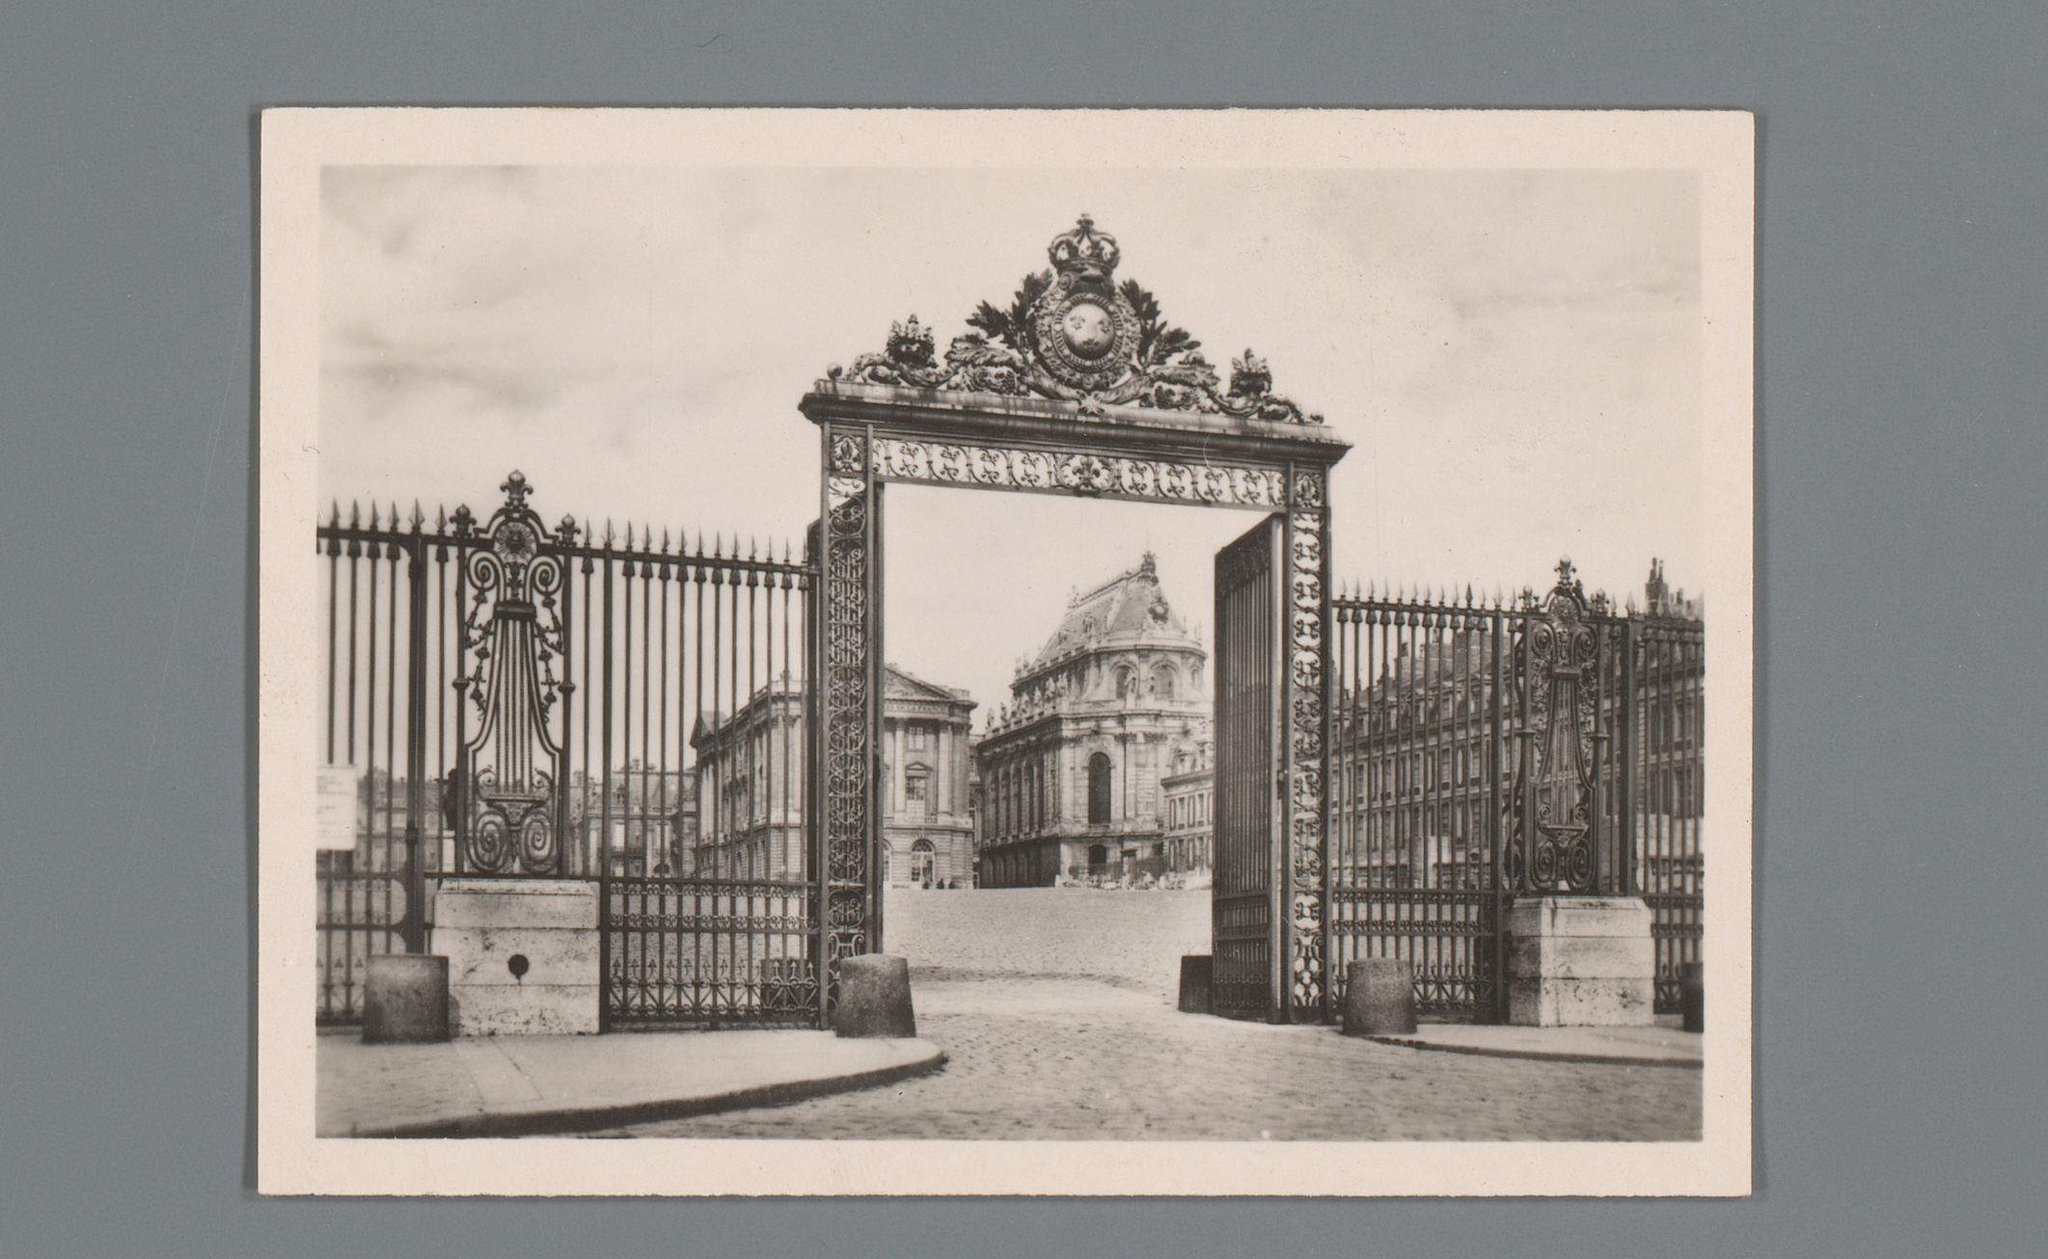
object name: photograph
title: Toegangspoort van Versailles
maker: Anonymous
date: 1900-1920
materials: paper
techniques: gelatin silver print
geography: versailles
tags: gate, entrance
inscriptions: number: ‘1’